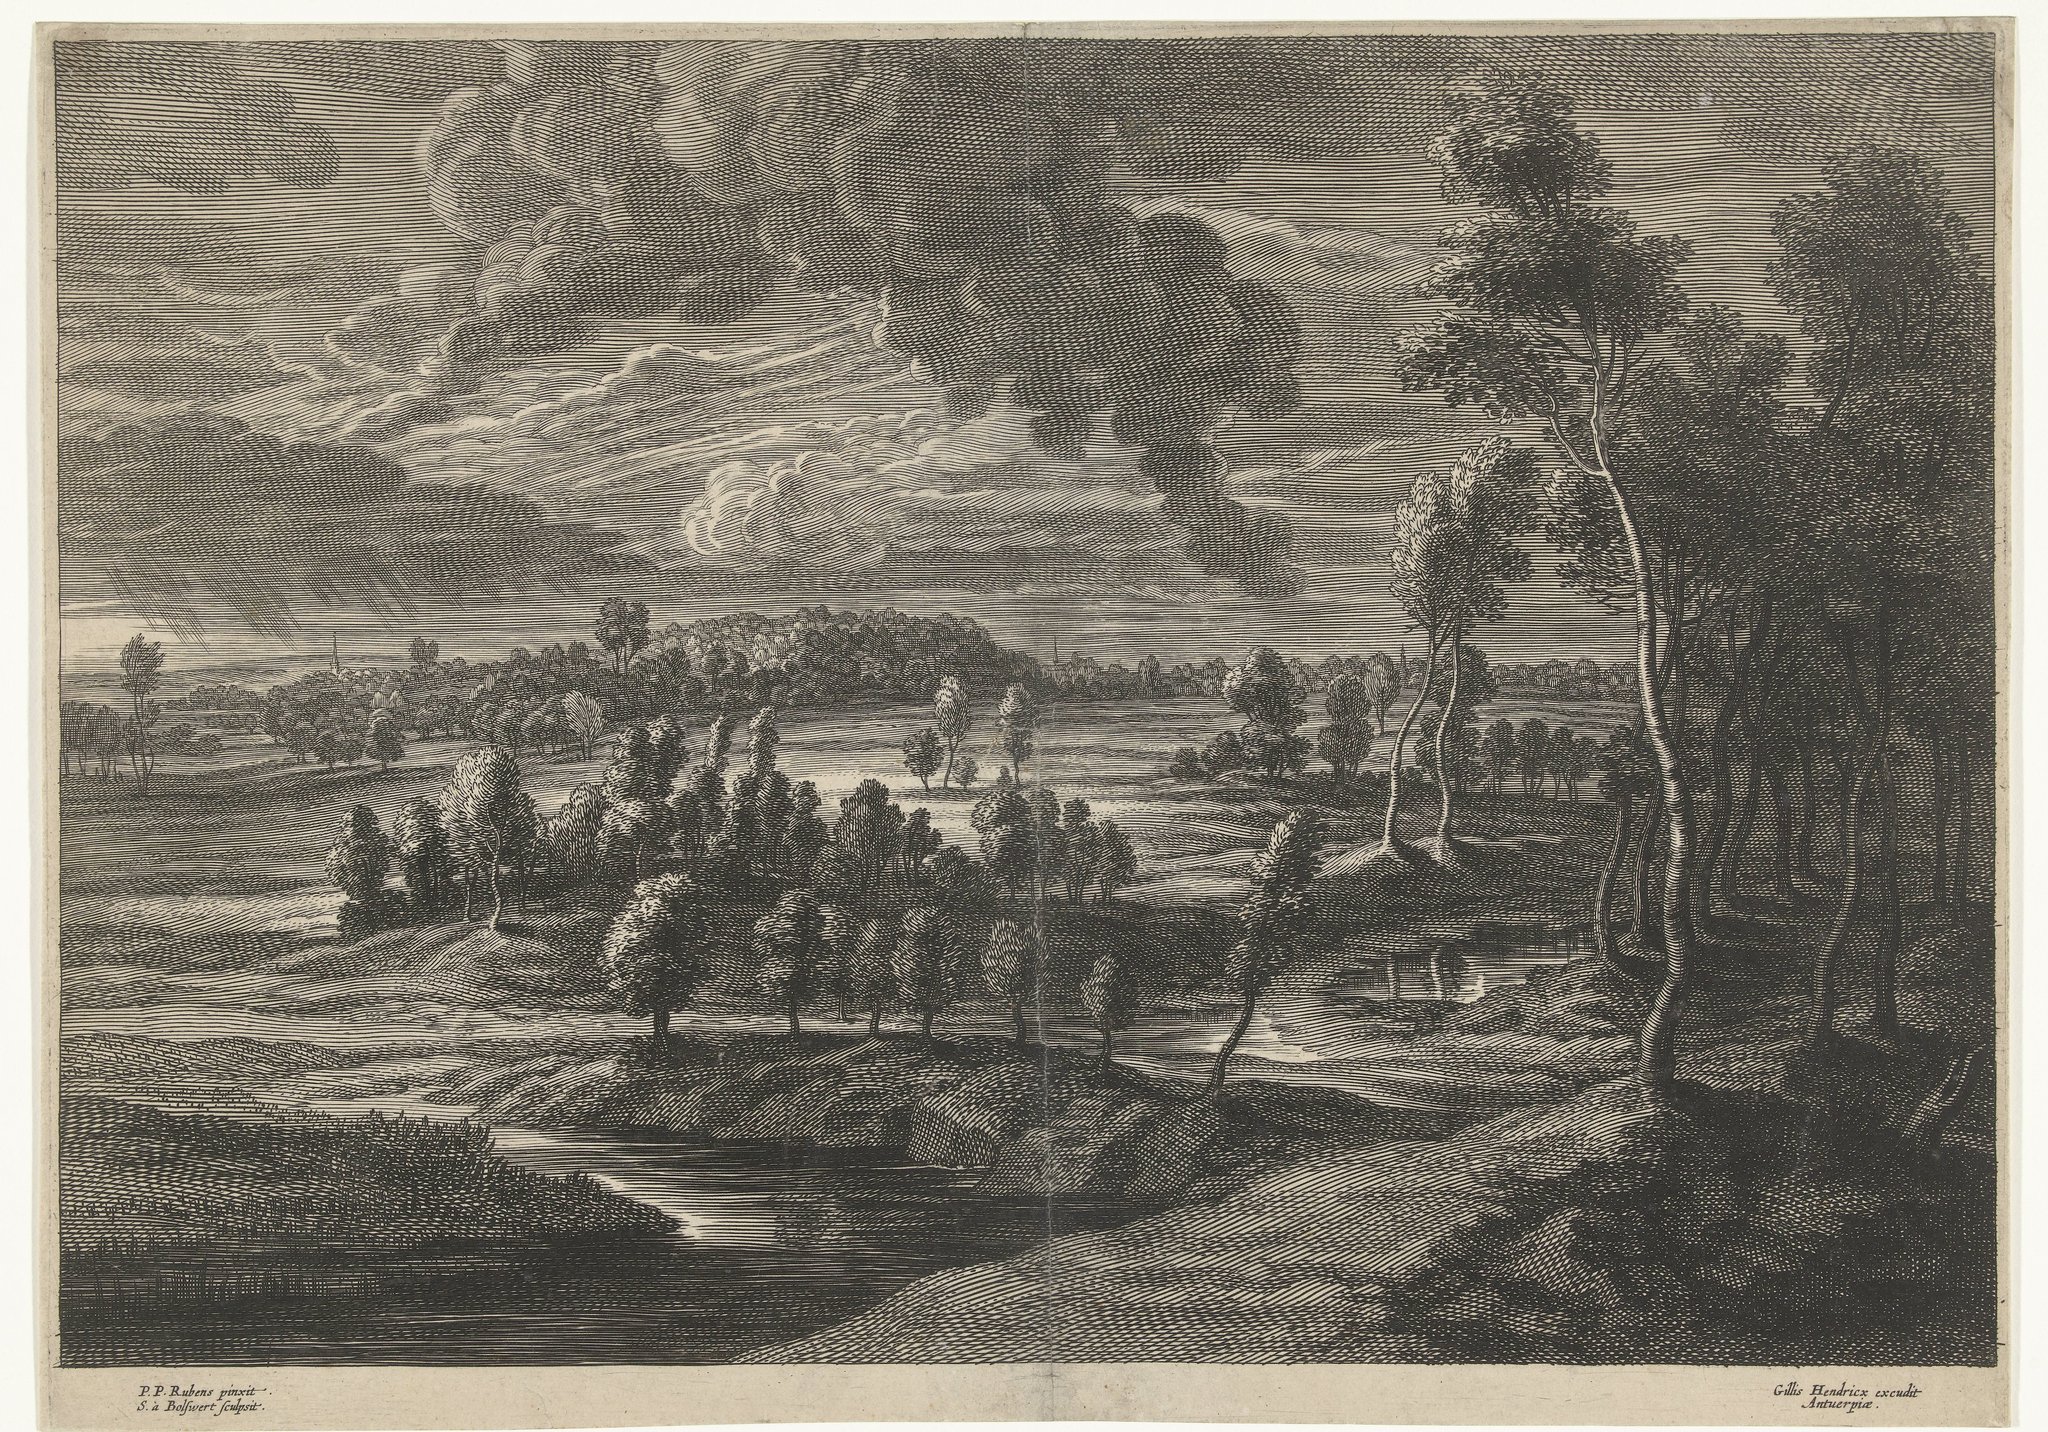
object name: print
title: Landschap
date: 1596-1659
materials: paper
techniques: engraving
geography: antwerp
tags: meadow, pasture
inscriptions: collector's mark: Lugt 240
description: Prent naar schilderij van Peter Paul Rubens. Hollstein beschrijft een serie kleine landschappen onder de nrs. 305 t/m 325 maar deze prenten zijn niet als reeks vervaardigd. In de collectie van het RMA bevinden zich vier verschillende staten van deze prent waarvan drie met een steeds afwijkend adres van de Antwerpse uitgever Gillis Hendricx. Dit blad is vervaardigd voor de gestoffeerde staten. Sporen van het Gillis Hendricx adres op deze plaat zijn nog zichtbaar op twee andere drukken in de collectie, in de marge rechtsonder een fragment met de laatste letters van het woord excudit (vergelijk RP-P-BI-2639 en RP-P-H-H-2171). En de eerste letters van de naam P.P. Rubens (vergelijk RP-P-BI-2639). Hieruit kunnen we opmaken dat het hier beschreven blad gedrukt is voor de andere staten in de collectie.